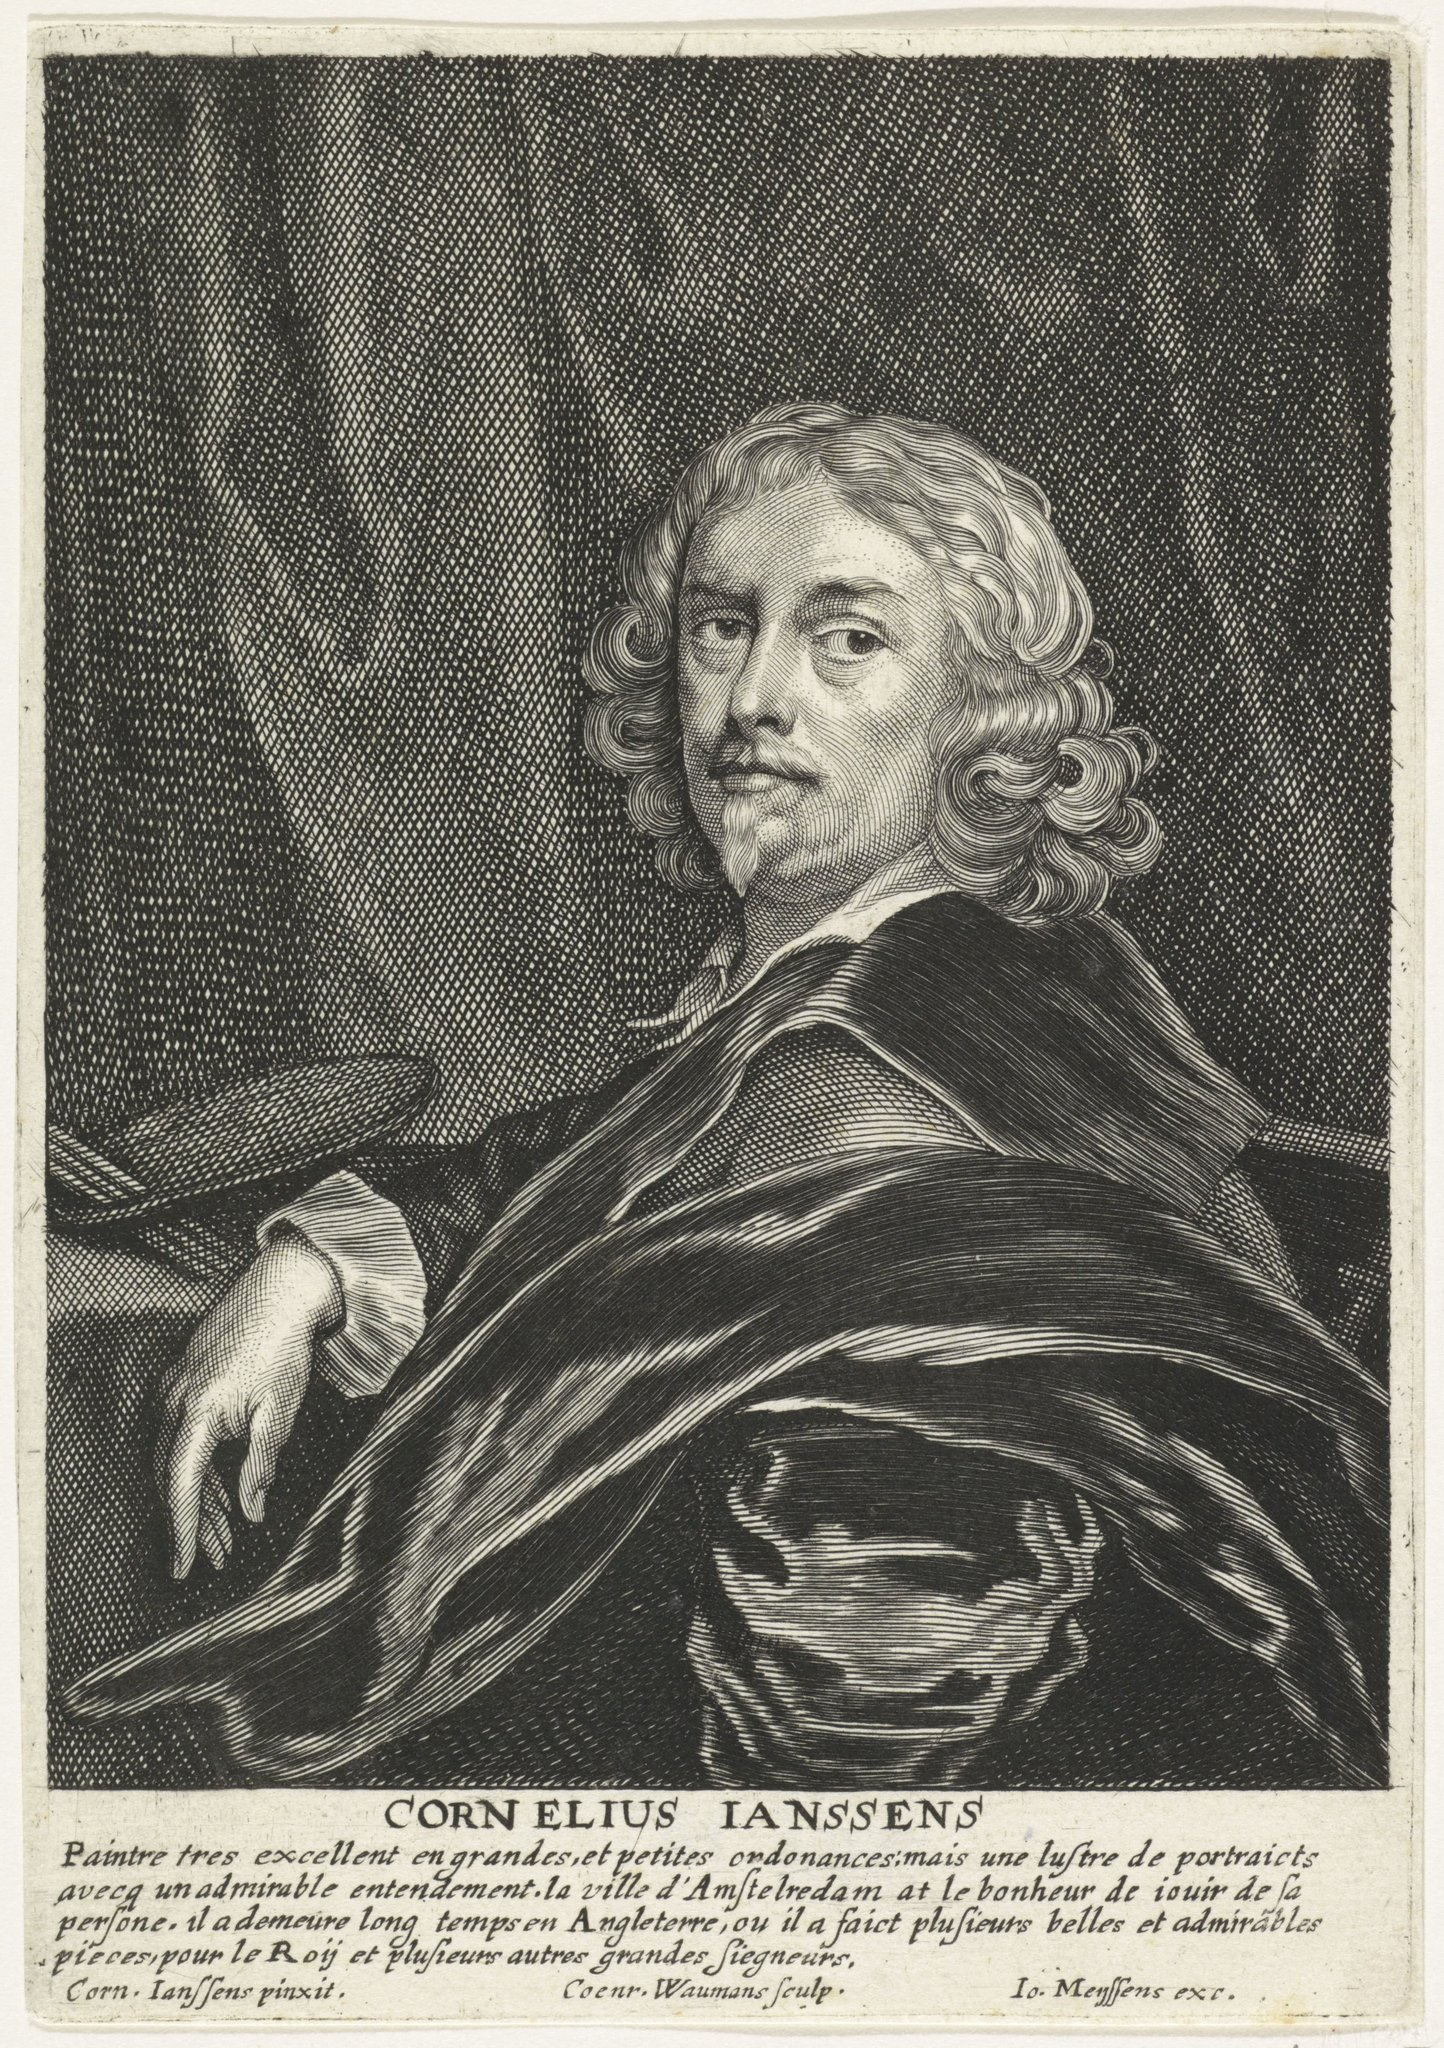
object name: print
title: Portret van de schilder Cornelis Jonson van Ceulen (I)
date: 1649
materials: paper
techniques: engraving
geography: antwerp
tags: london, utrecht, painter, draughtsman, cornelis janssens van ceulen i, portrait, self-portrait of painter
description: Prent gebruikt in: Image de divers hommes d'esprit sublime, qui par leur art et science devraient vivre éternellement et desquels la louange et renommée faict estonner le monde. Antwerpen: J. Meyssens, 1649.